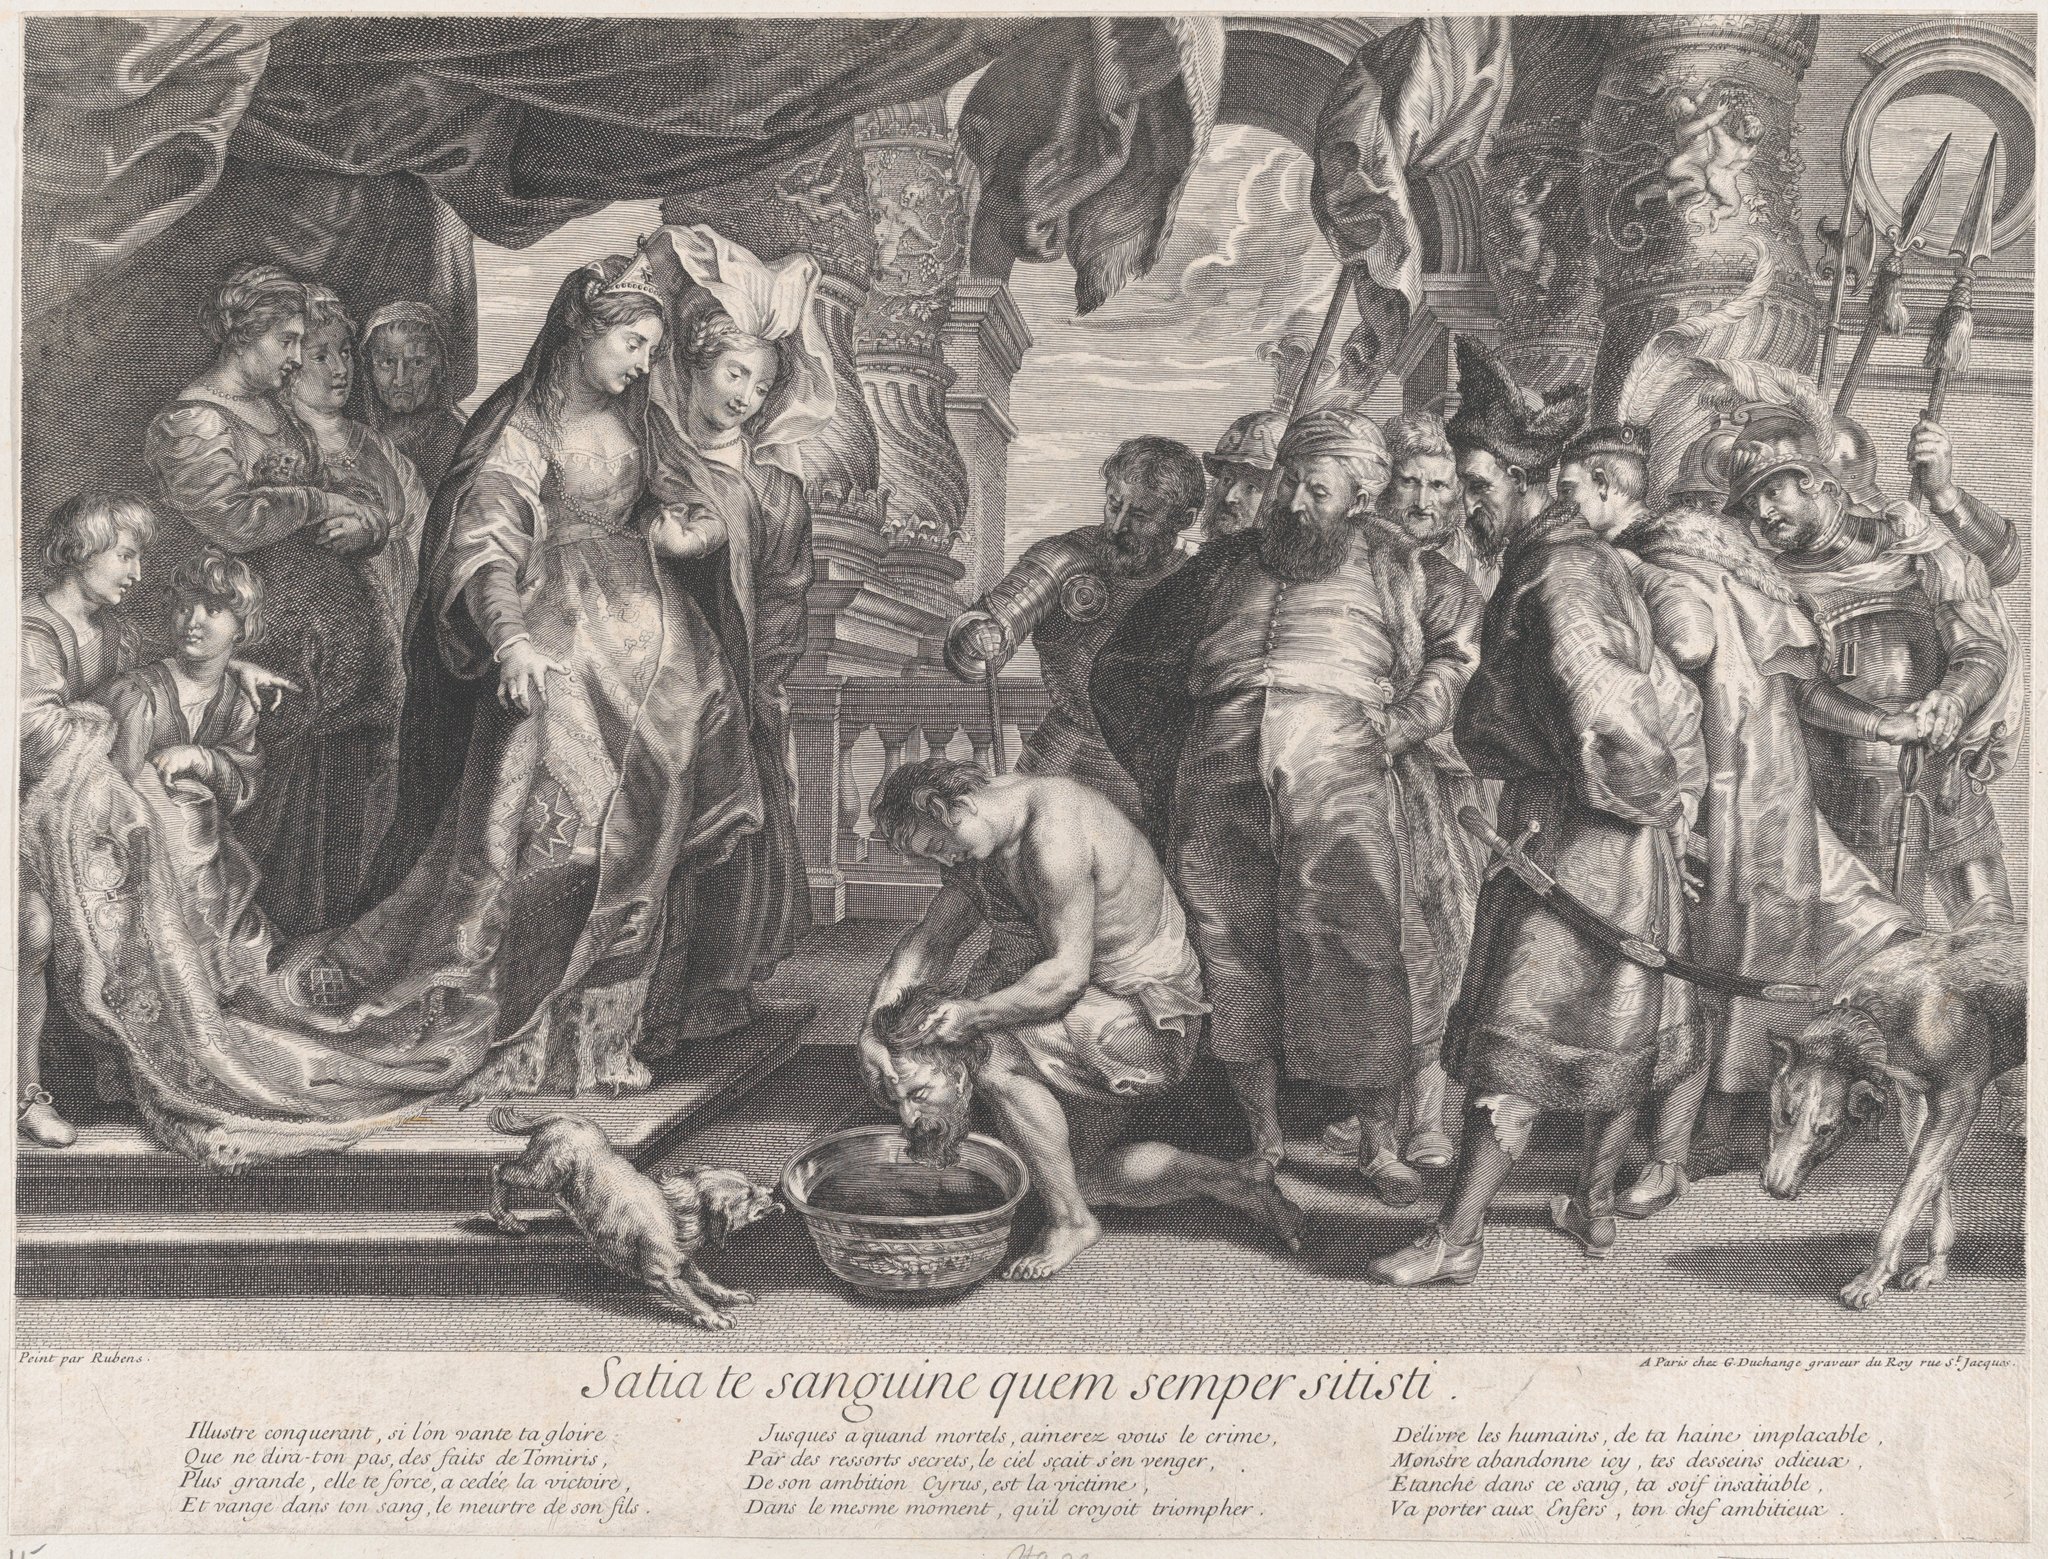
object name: print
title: The Head of Cyrus brought to Queen Tomyris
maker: gaspard duchange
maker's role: artist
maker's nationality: french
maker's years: 1662-1757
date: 1713-1720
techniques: engraving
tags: queens,heads,men,women,dogs